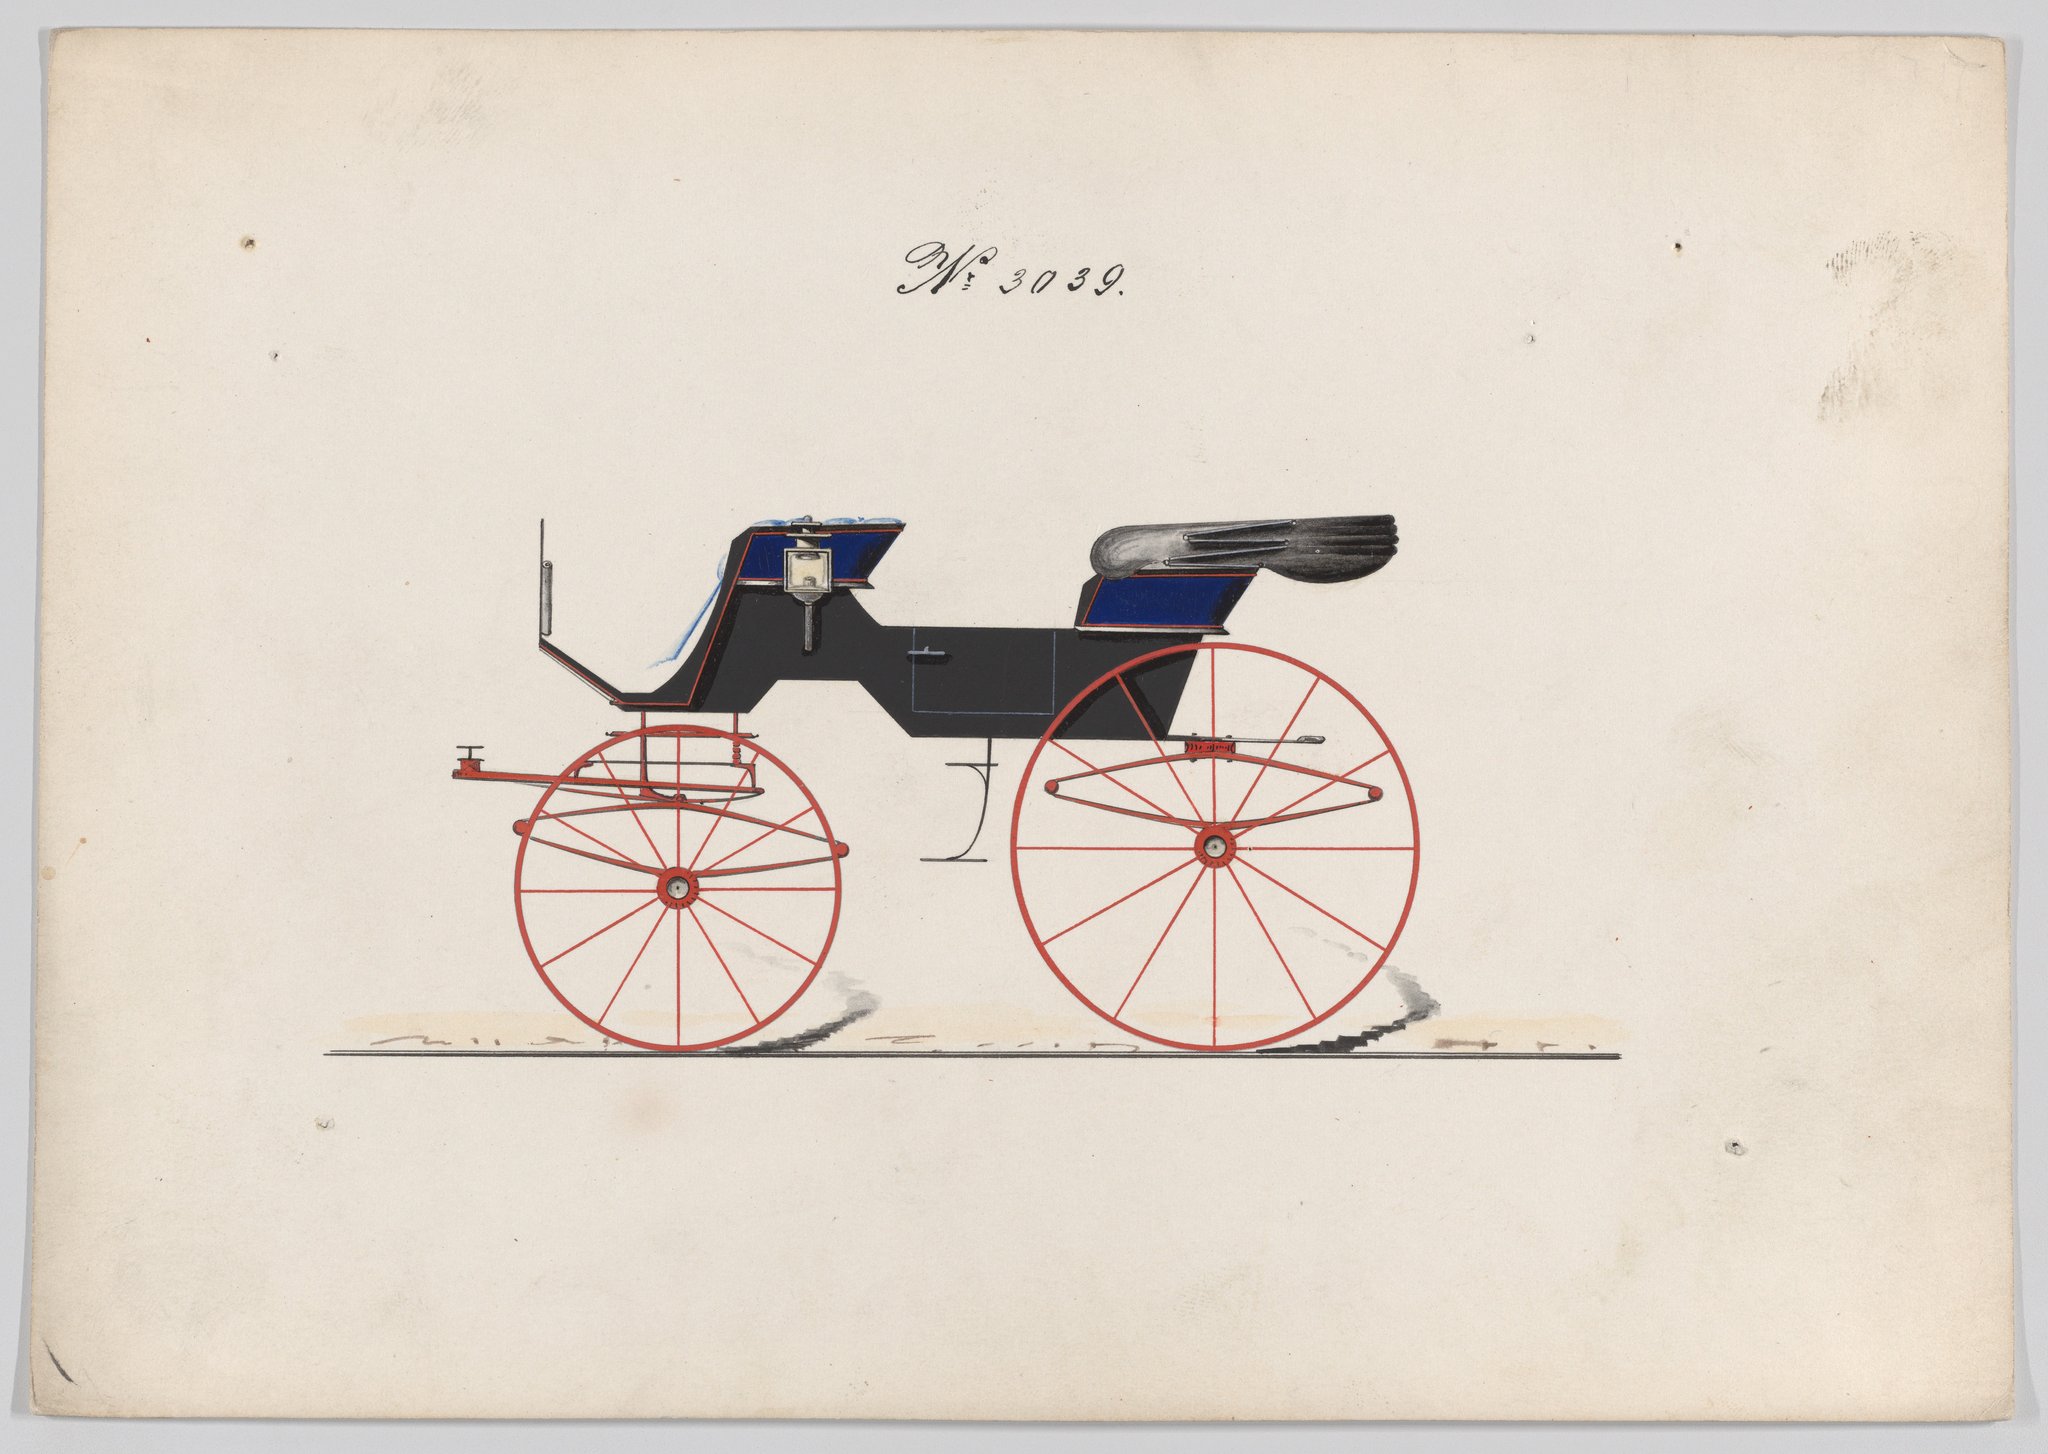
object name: drawing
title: Design for 2 seat Phaeton, no. 3039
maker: brewster & co.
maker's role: manufacturer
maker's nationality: american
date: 1874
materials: gouache, gum arabic, ink, watercolor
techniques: pen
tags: carriages